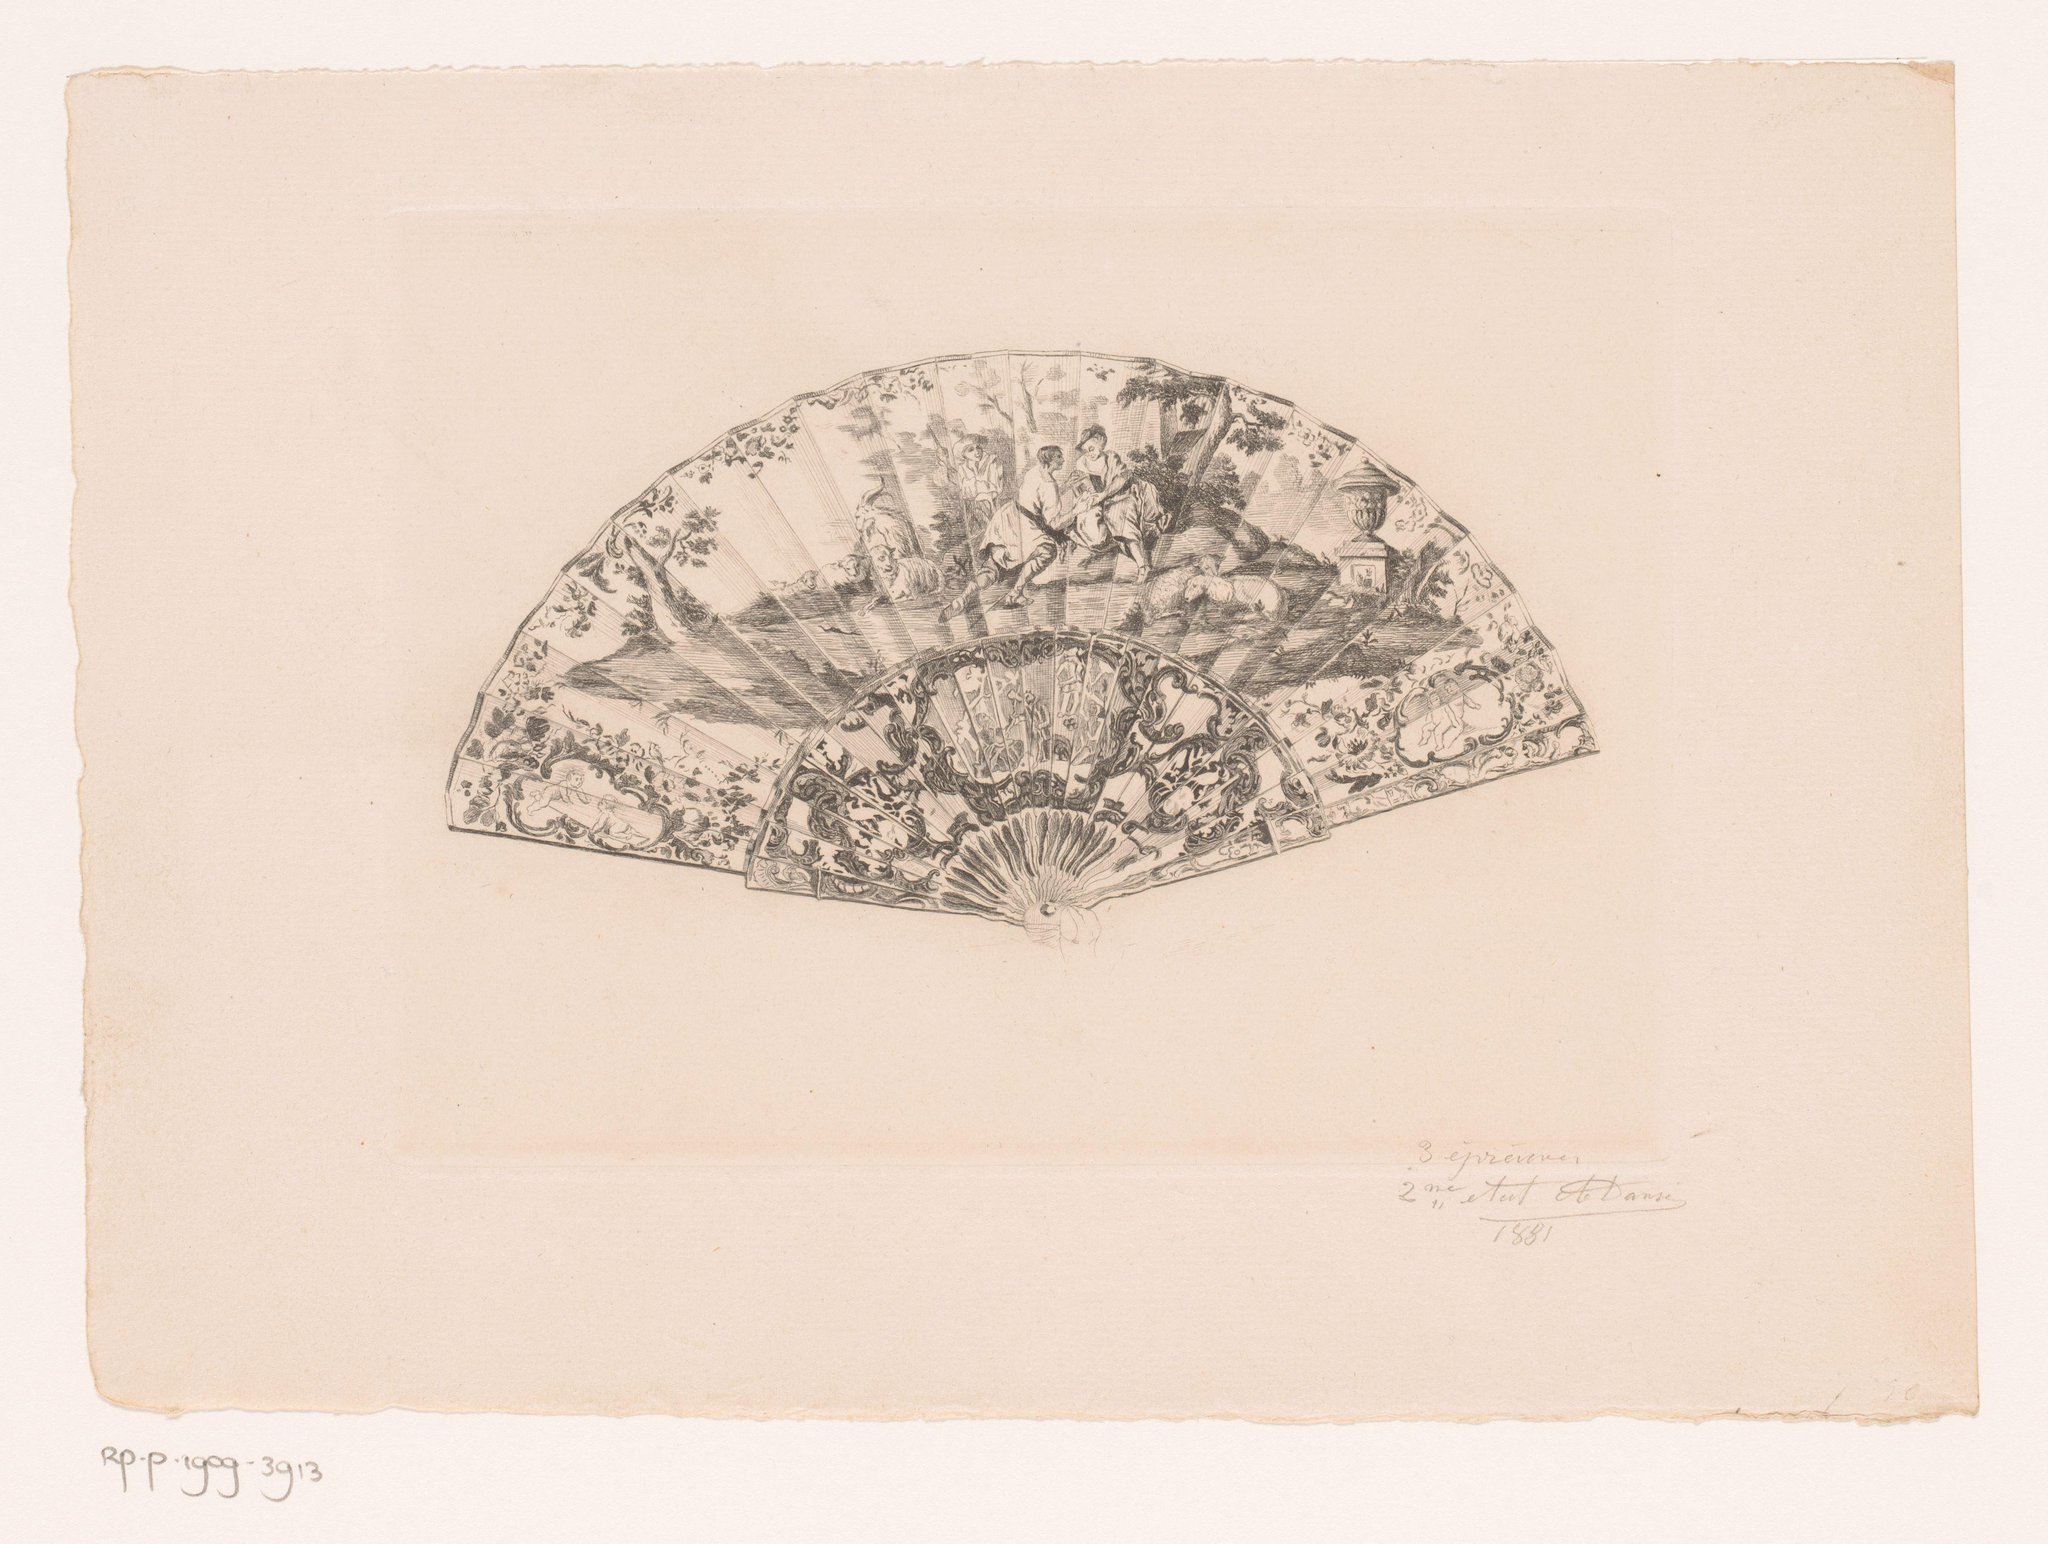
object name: print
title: Waaier met pastorale scène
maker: auguste danse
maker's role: print maker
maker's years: 1829-1929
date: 1881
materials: paper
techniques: etching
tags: fan, pastorals, arcadian scenes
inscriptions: annotation: ‘3 épreuves 2me etat’, collector's mark: Lugt 2228